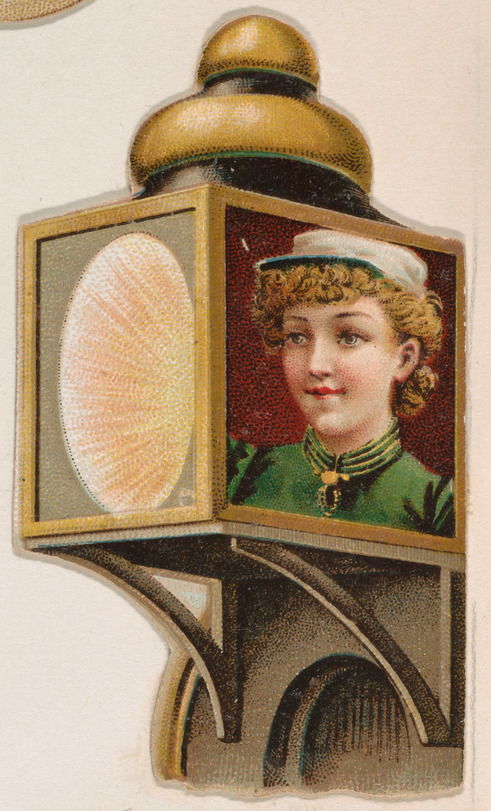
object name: print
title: Headlight, from the Novelties series (N228, Type 3) issued by Kinney Bros.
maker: kinney brothers tobacco company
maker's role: publisher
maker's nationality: american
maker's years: 1869-2011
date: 1889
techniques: color lithograph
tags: women